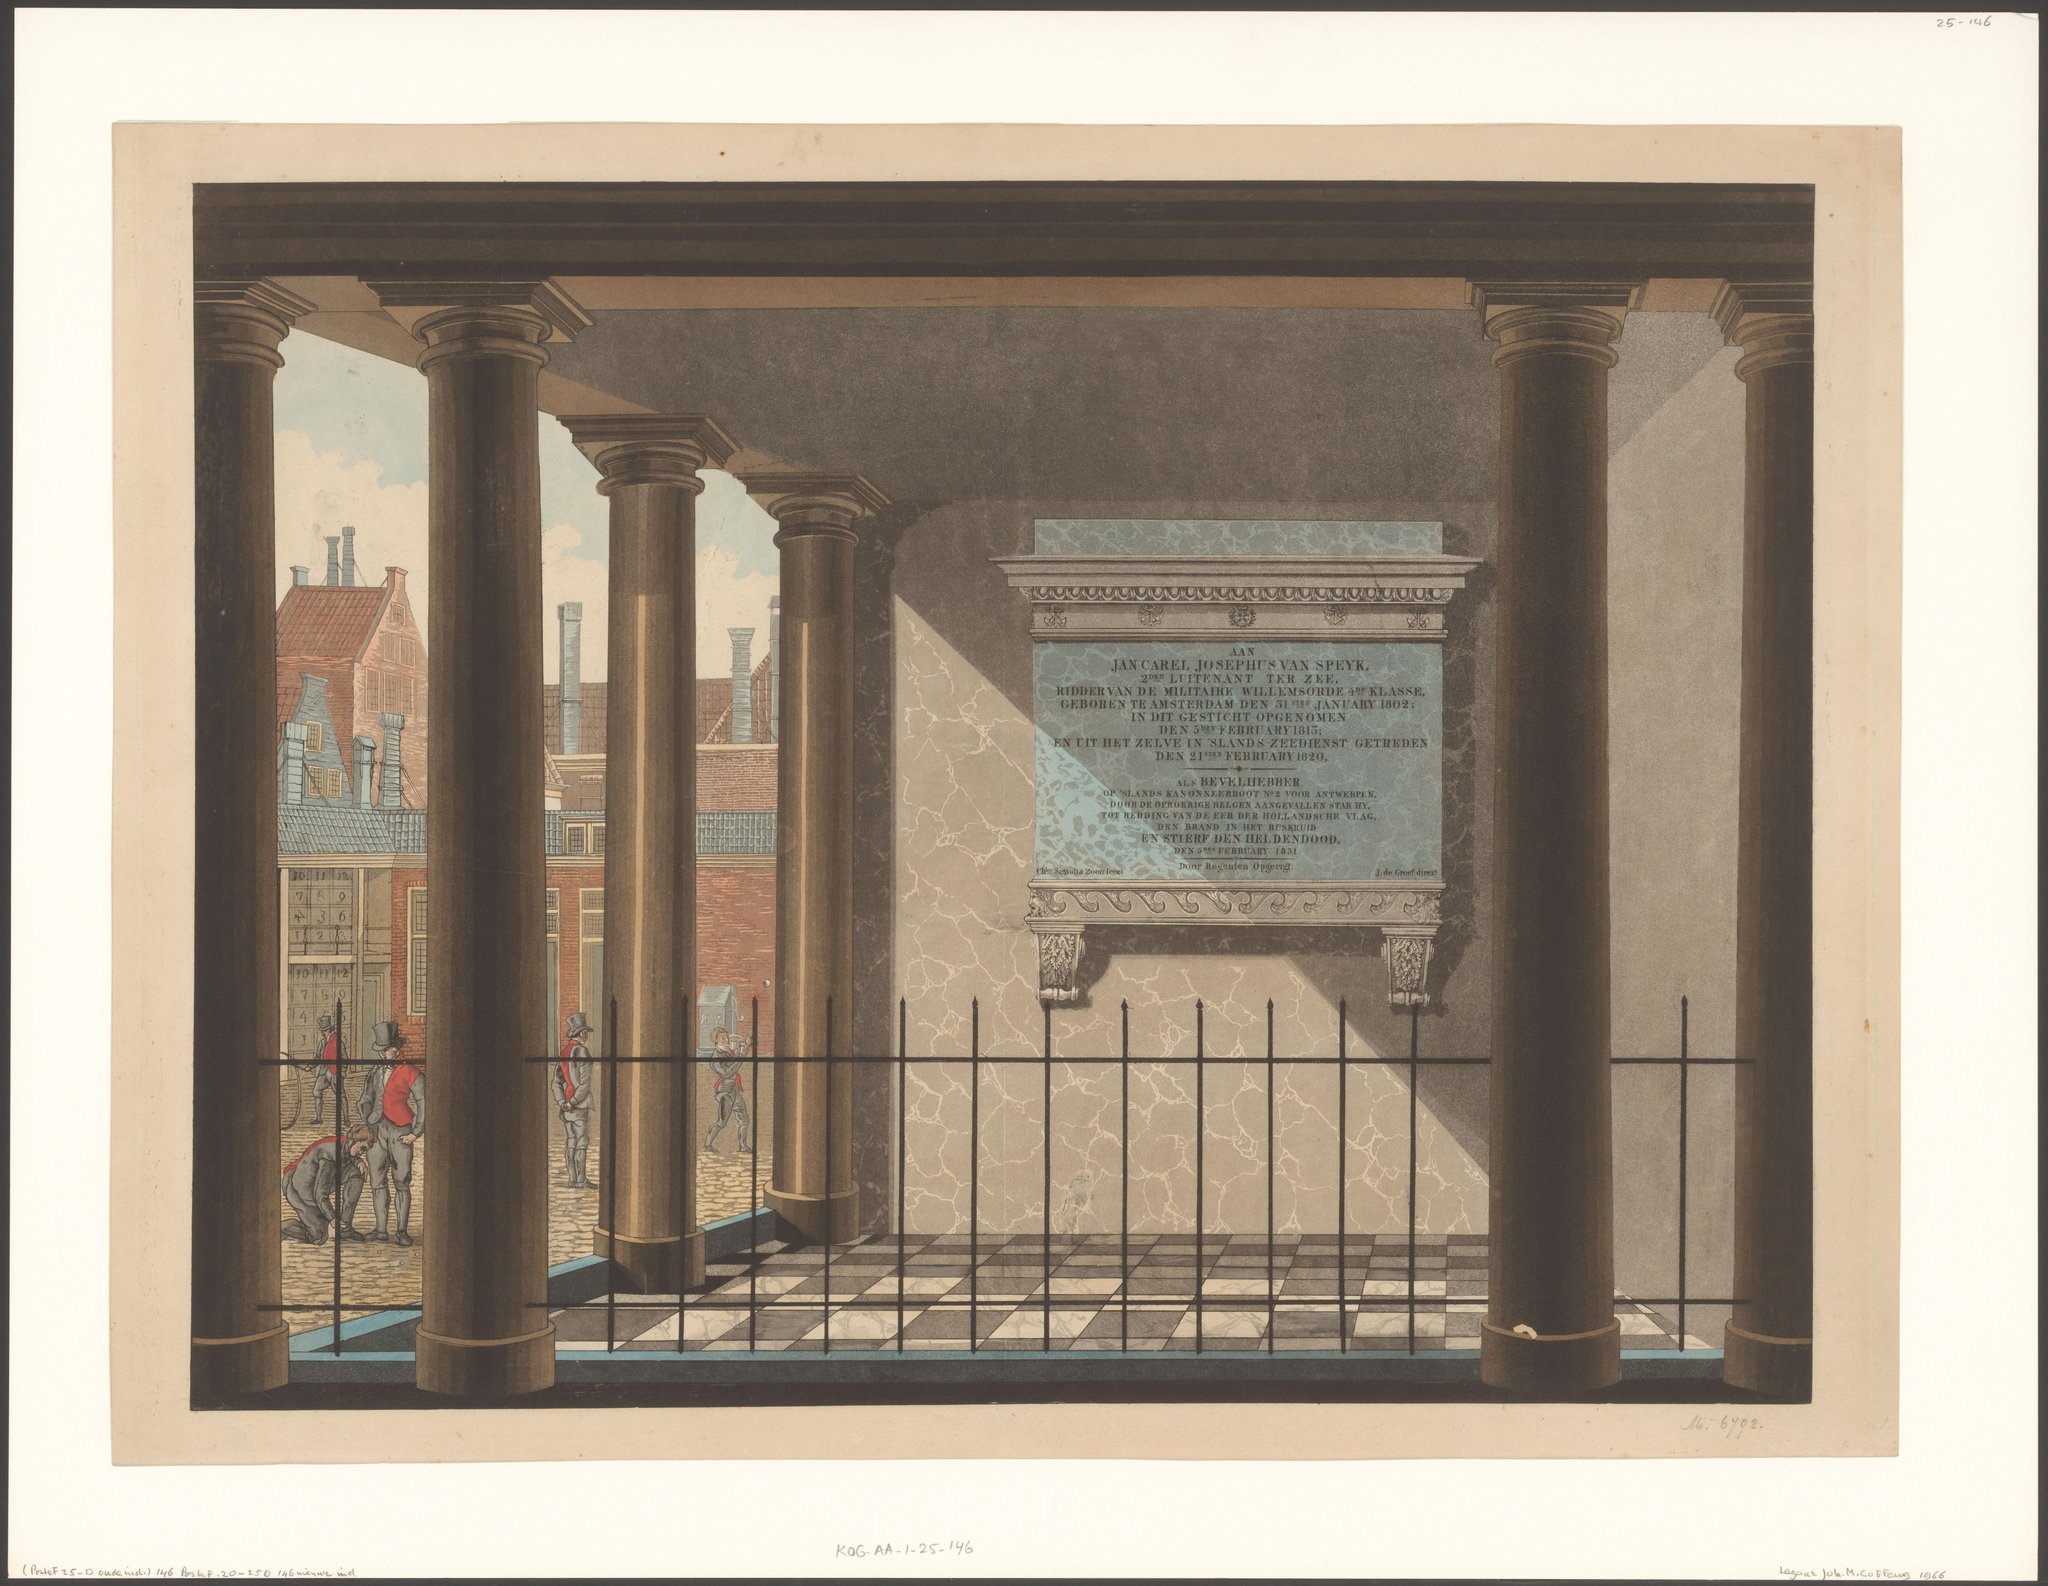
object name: print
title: Gedenkteken voor Jan van Speyk op de binnenplaats van het Burgerweeshuis te Amsterdam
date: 1831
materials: paper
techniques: aquatint, etching, hand coloring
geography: amsterdam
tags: amsterdam, antwerp, jan van speyk, column, pillar ~ architecture, courtyard, monumental adornments (in city), commander-in-chief, admiral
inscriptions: collector's mark: ‘25.146’ Lugt 1641b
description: Gedenksteen opgedragen aan Jan Carel Josephus van Speyk. De gedenkplaat is van vader en zoon Sigault, in opdracht van architect Jan de Greef, geplaatst op de binnenplaats van het Burgerweeshuis te Amsterdam.